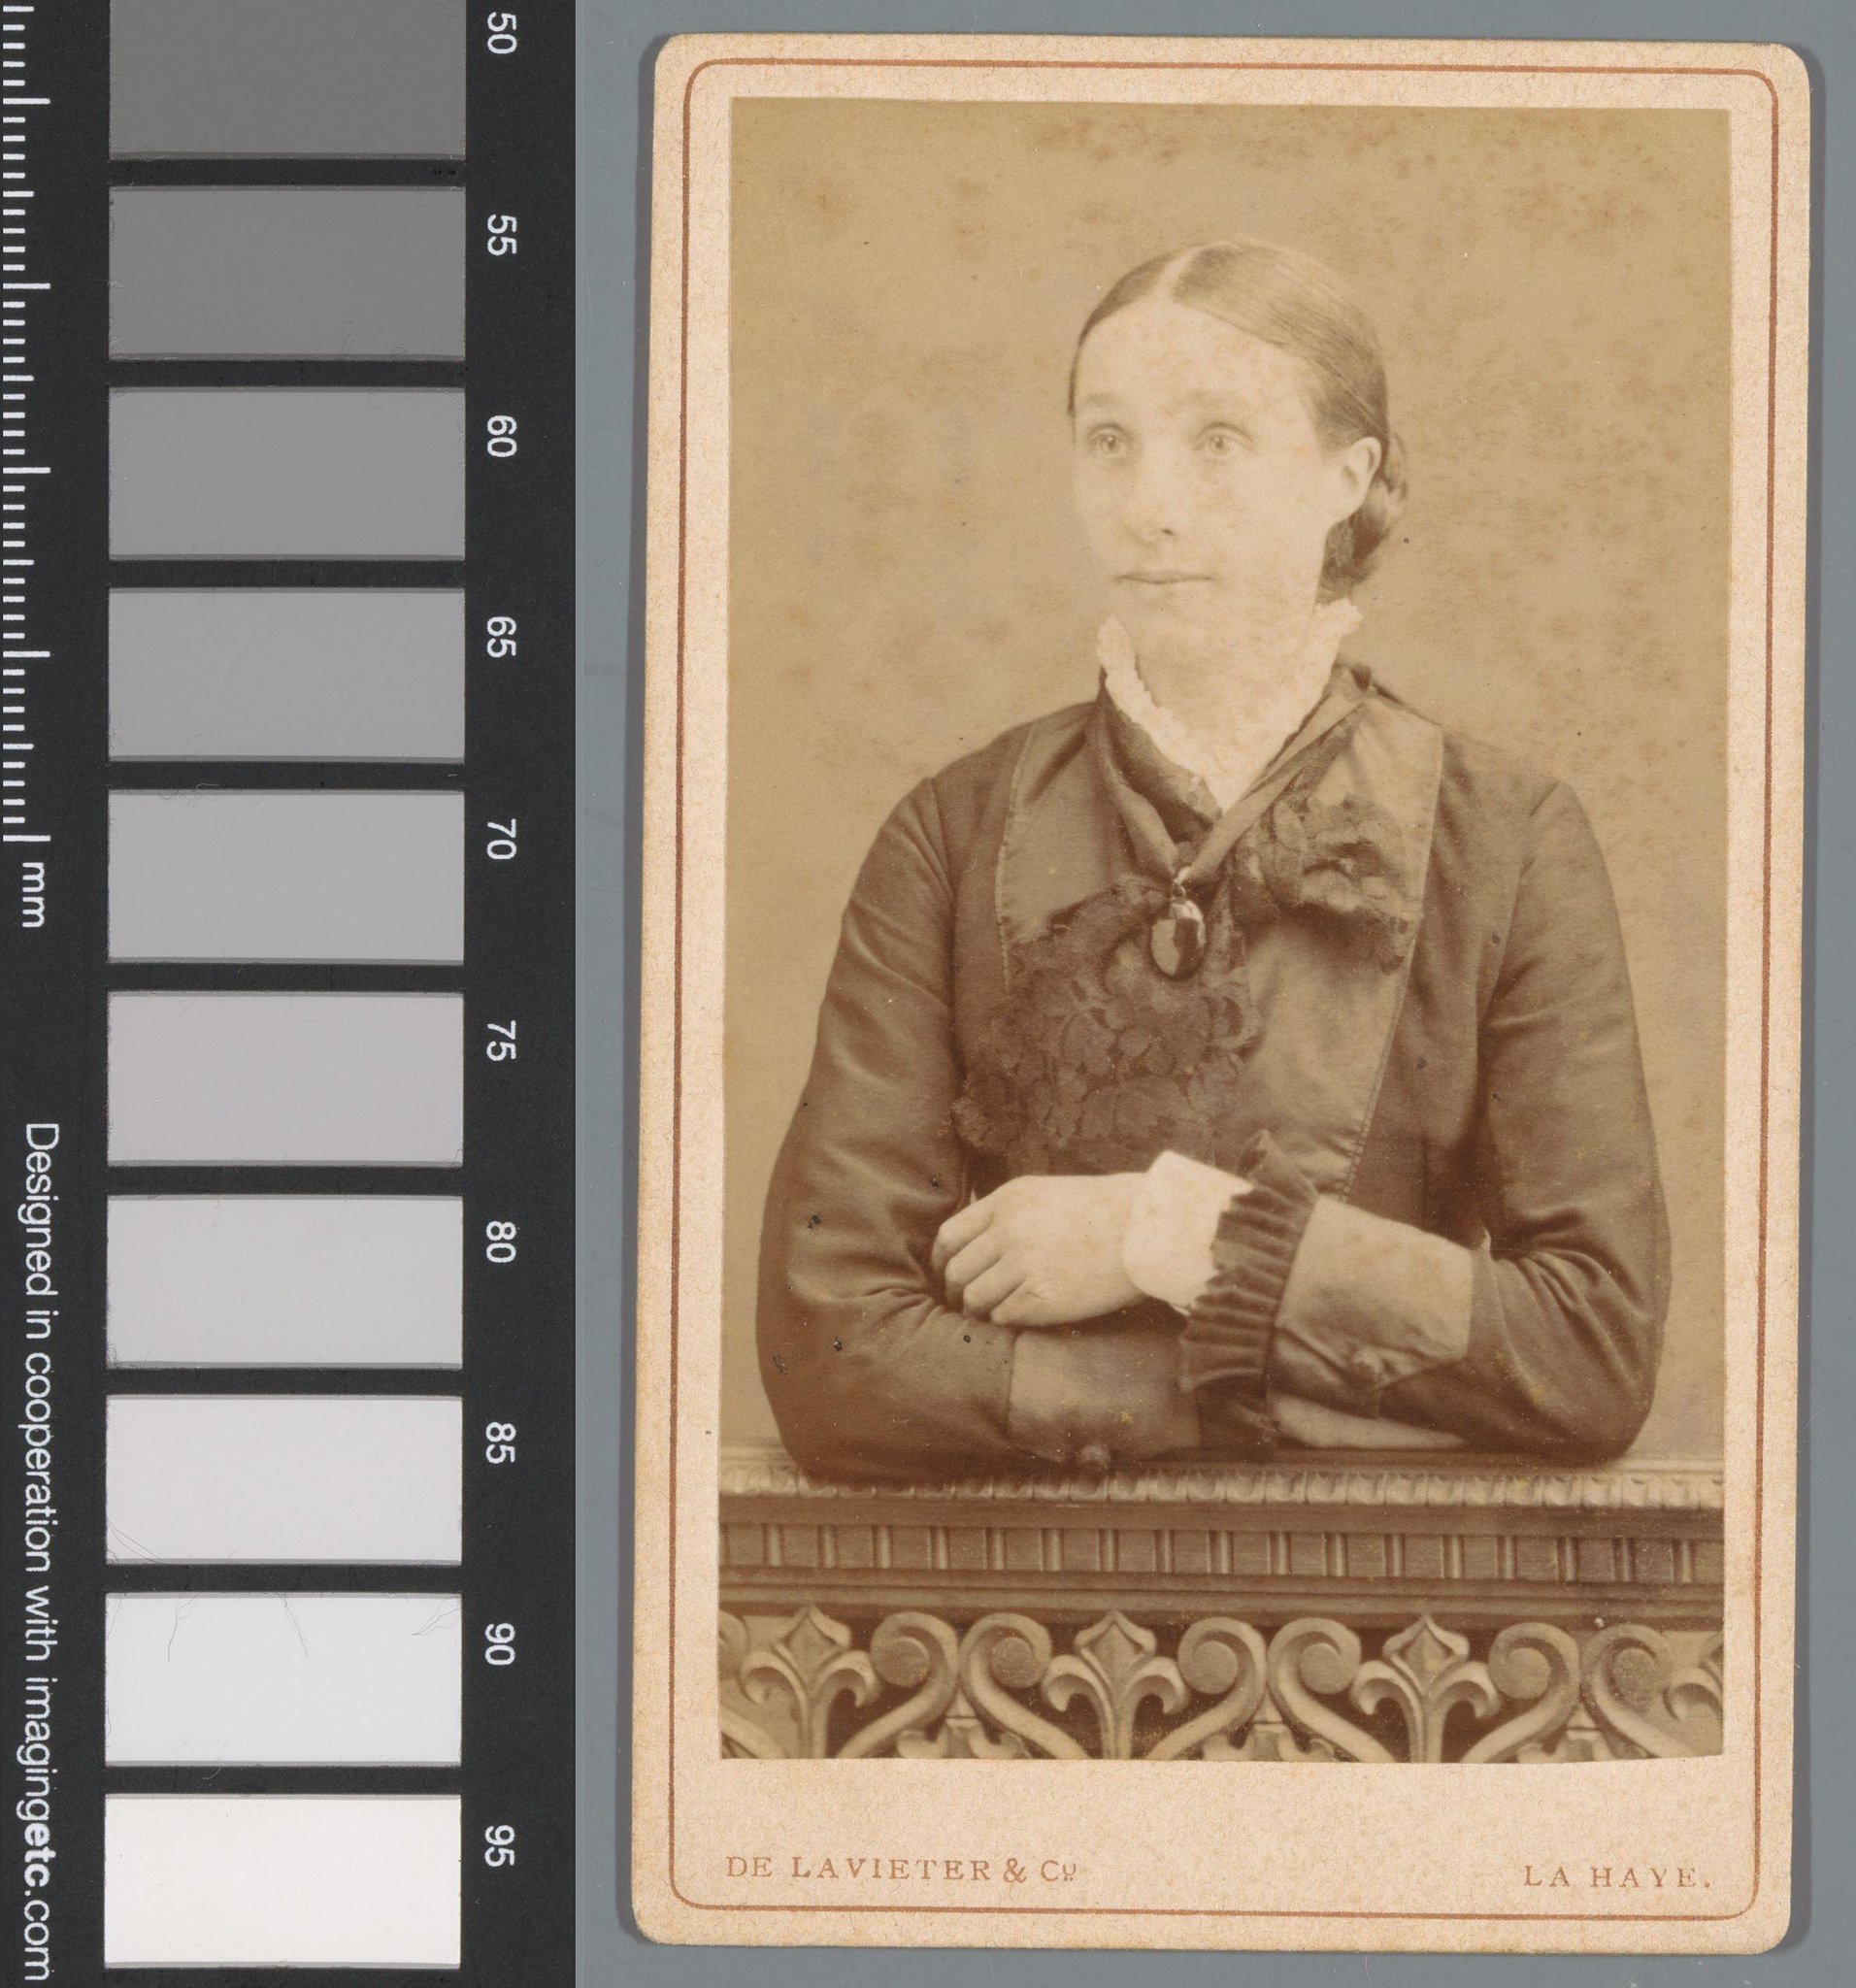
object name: photograph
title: Portret van een onbekende vrouw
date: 1865-1903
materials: cardboard, paper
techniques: albumen print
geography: the hague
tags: historical persons - bb - woman, arms folded over the abdomen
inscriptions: inscription: ‘DE LAVIETER & Co./ PHOTOGRAPHES DE S.M. LE ROI./ DE S. A. R. LE PRINCE D'ORANGE/ ET DE S. A. R. MADAME LA PRINCESSE HENRI/ DES PAYS BAS/ 2. Willemstraat. LA HAYE.’